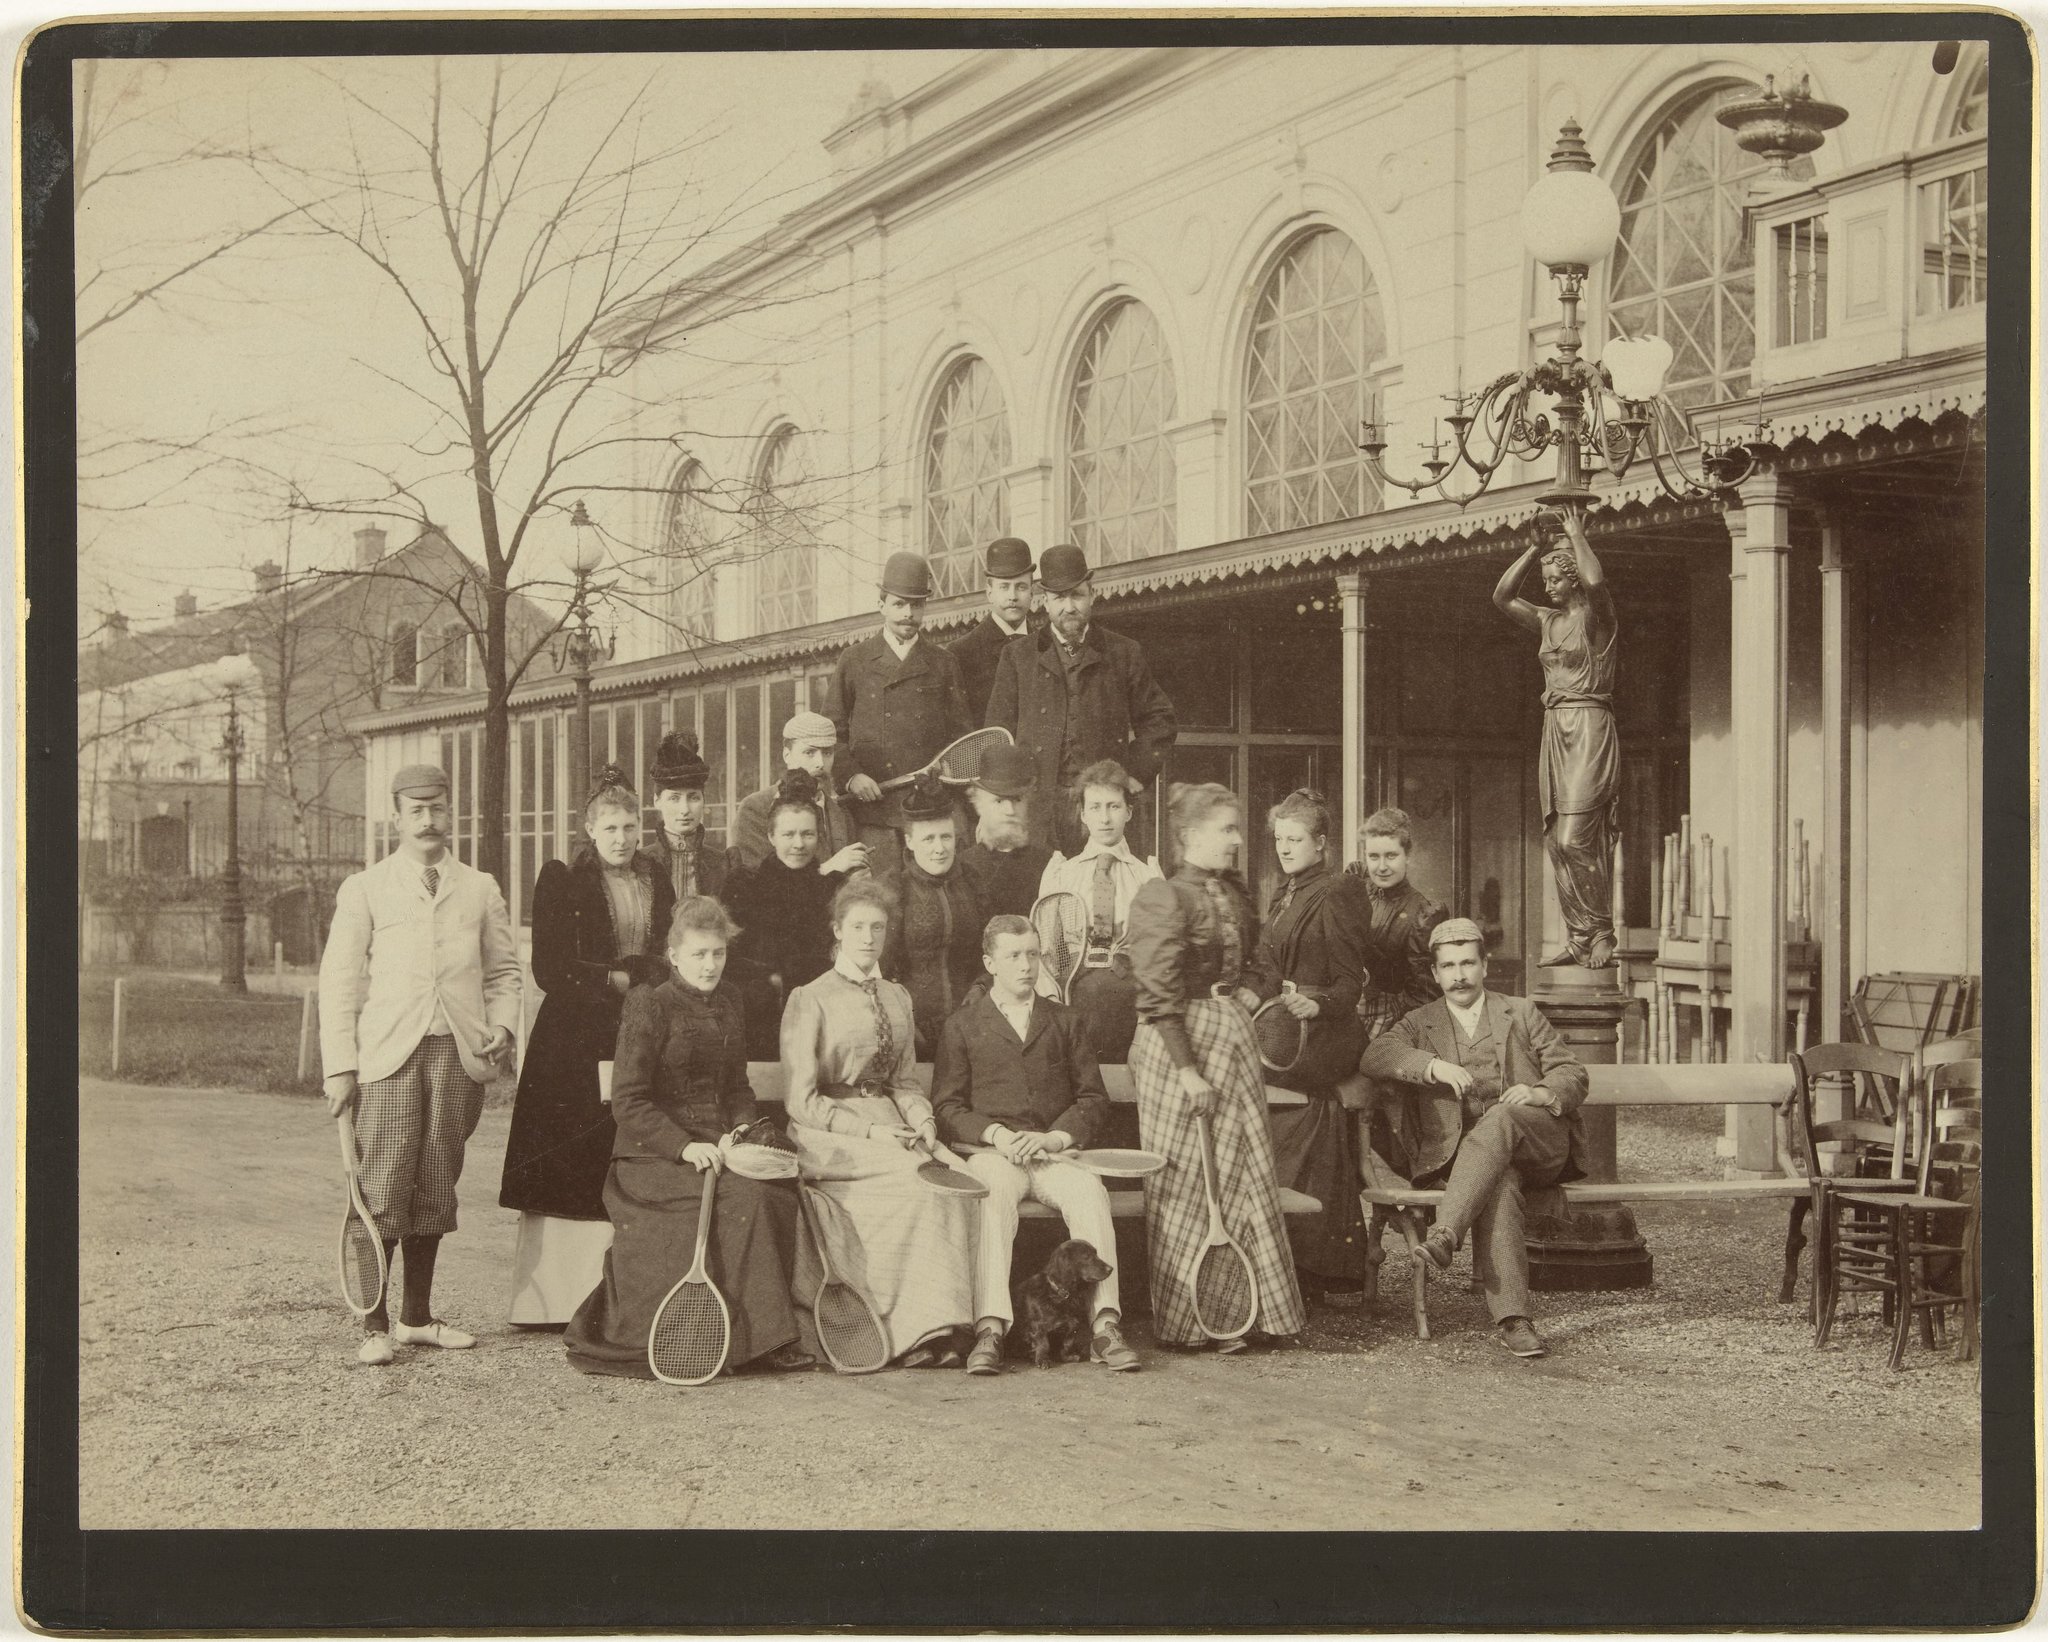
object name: photograph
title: Group Portrait at the Tennis Club, with the photographer at the Far Left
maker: henry pauw van wieldrecht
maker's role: fotograaf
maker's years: 1863-1912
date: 1892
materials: cardboard, photographic support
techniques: albumen print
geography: netherlands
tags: zeist, henry pauw van wieldrecht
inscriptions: annotation: ‘vader’, annotation: ‘No. 27. 504 1892.’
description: Tennis, horseback riding, bicycling, and hunting, in a nutshell this is what we see in the pictures taken by a late 19th-century amateur photographer. Primarily young people recorded these kinds of scenes. It should be clear that most of these amateurs were from affluent circles. Photography was expensive and time consuming.